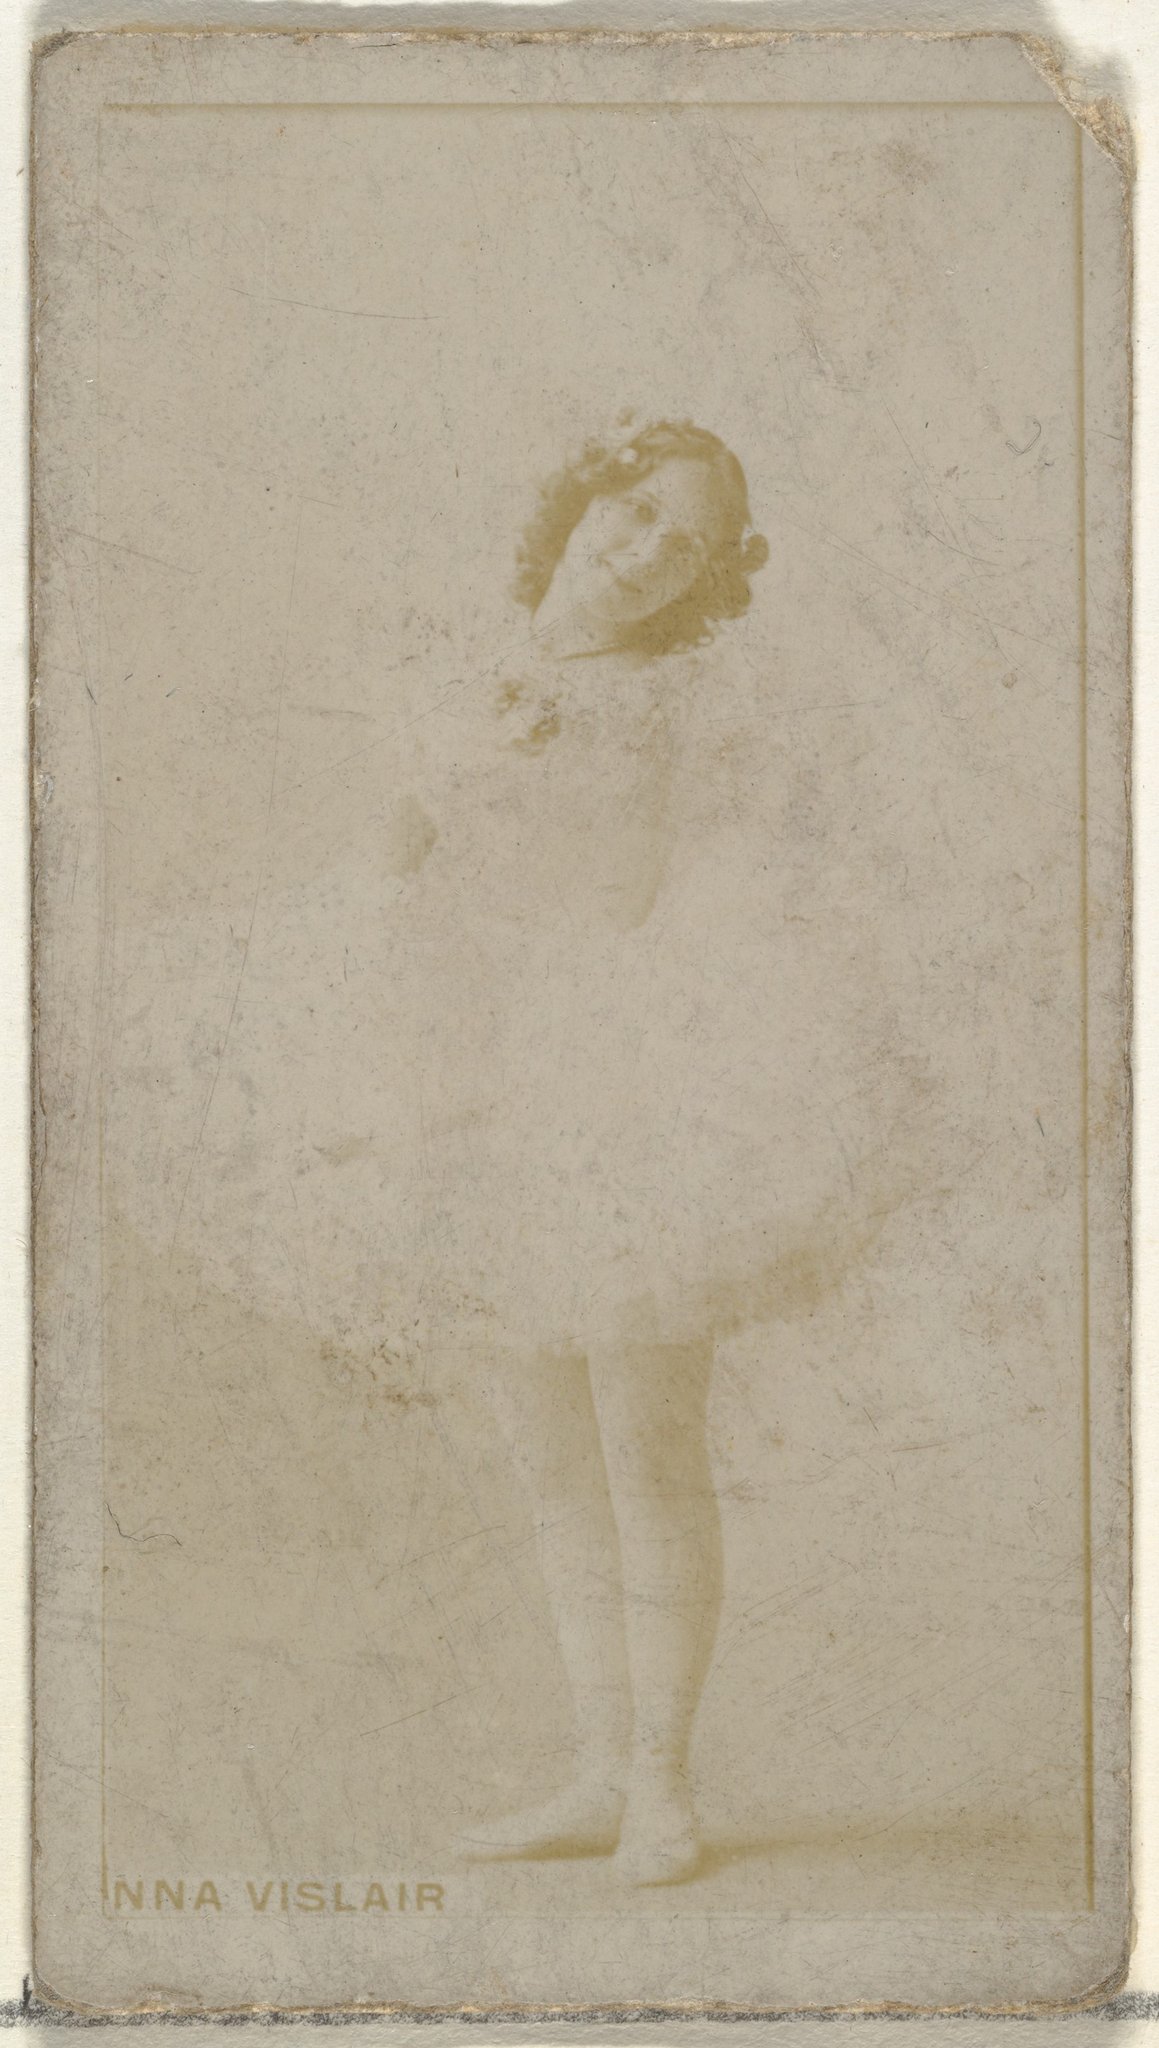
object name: photograph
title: Anna Vislair, from the Actors and Actresses series (N145-8) issued by Duke Sons & Co. to promote Duke Cigarettes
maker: w. duke, sons & co.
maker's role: publisher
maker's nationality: american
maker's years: 1870-1920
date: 1891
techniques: albumen silver print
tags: portraits,women,actresses